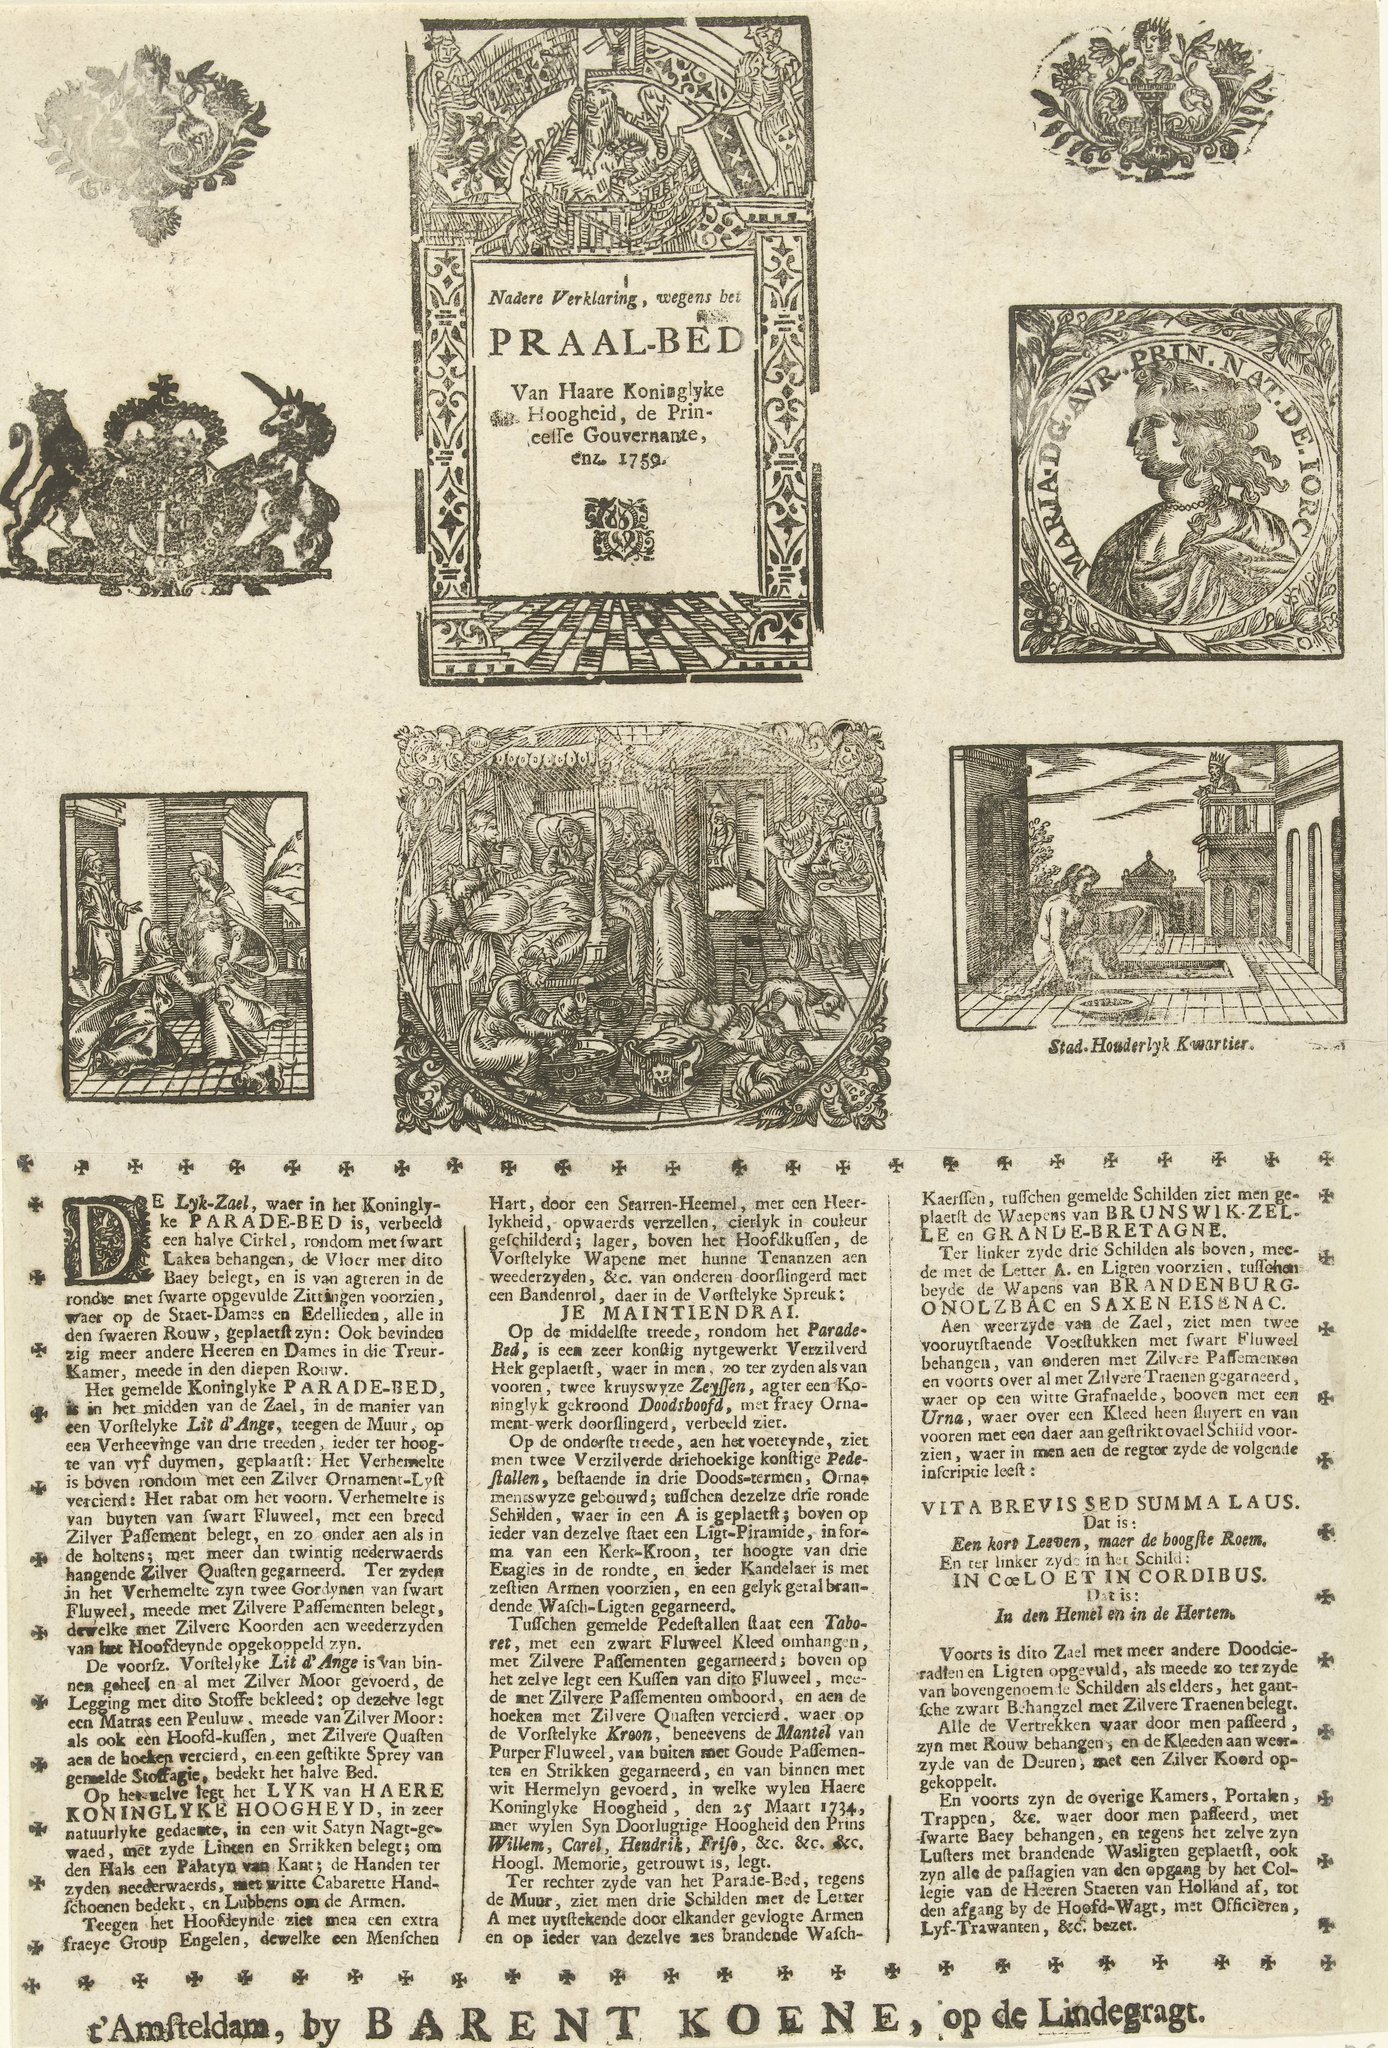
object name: print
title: Nadere Verklaring, wegens het Praal-Bed Van Haare Koninglyke Hoogheid, de Princesse Gouvernante, enz. 1759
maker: barend koene (i)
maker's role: bookseller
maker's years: -1800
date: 1759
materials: paper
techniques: letterpress printing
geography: amsterdam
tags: anna van hannover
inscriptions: collector's mark: Lugt 2228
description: Blad met in drie kolommen een beschrijving van de paradezaal en het praalbed waarop de op 12 januari 1759 overleden prinses Anna van Hannover gedurende enkele dagen in februari opgebaard heeft gelegen. Op de bovenste helft van het blad staan acht oude houtsneden met diverse onderwerpen waaronder een kraambed en enkele bijbelse scènes.